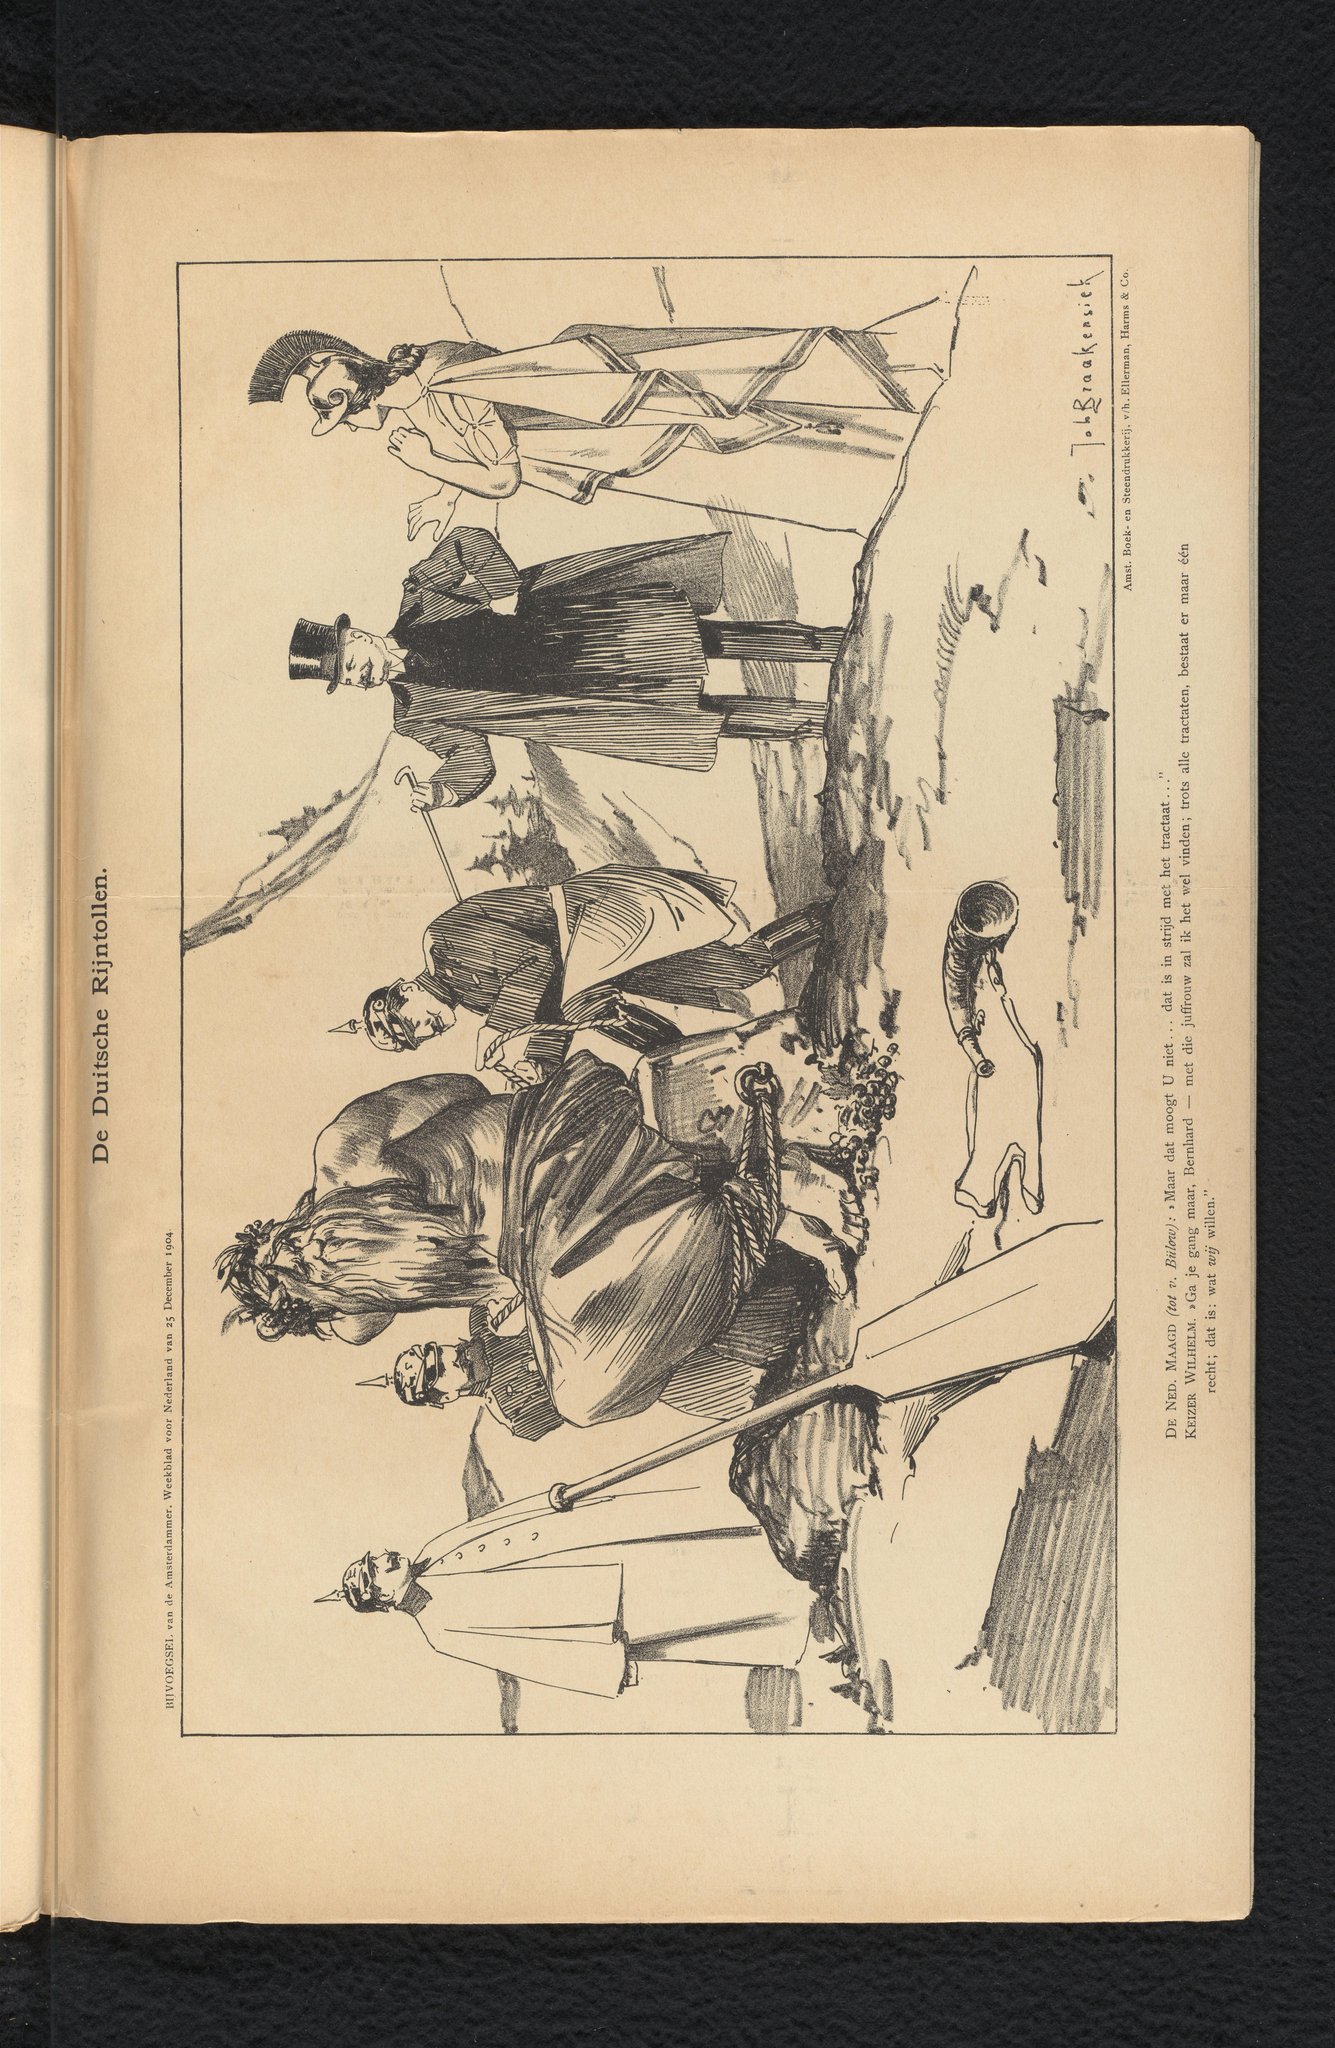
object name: cartoon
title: De Duitsche Rijntollen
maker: johan braakensiek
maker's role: draughtsman, print maker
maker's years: 1858-1940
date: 1904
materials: paper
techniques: lithograph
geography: netherlands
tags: wilhelm ii (keizer van duitsland), personifications of countries, nations, states, districts, etc., toll gate, political caricatures and satires, river personified: rhine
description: Duitse militairen binden op gezag van keizer Wilhelm II en kanselier Von Bülow de riviergod van de Rijn met touwen vast. De klacht van de Nederlandse Maagd over het heffen van tol op de Rijn wordt door de kanselier afgewimpeld.